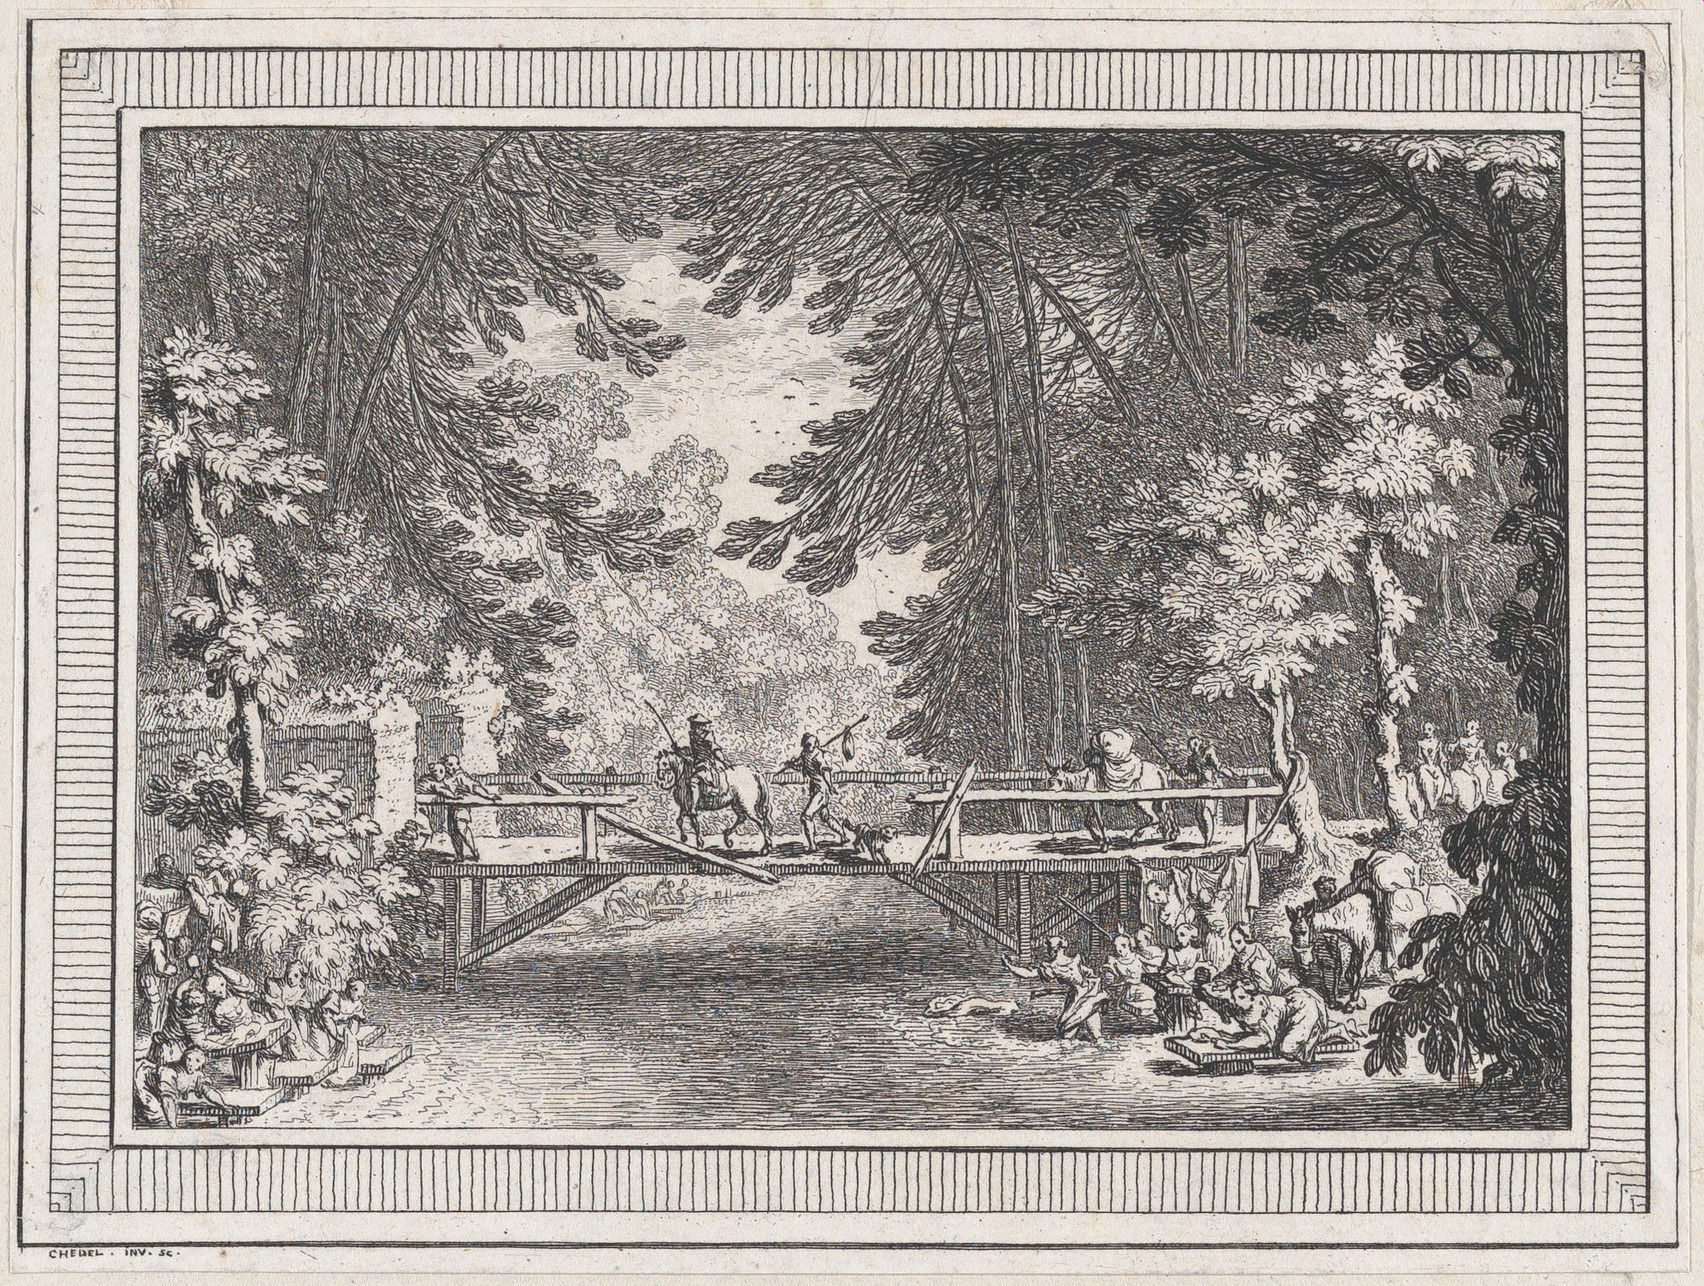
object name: print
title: Landscape, from a series of six landscapes dedicated to Madame La Marquise de Pompadour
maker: quentin pierre chedel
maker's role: artist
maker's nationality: french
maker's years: 1705-1763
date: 1701-1800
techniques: etching